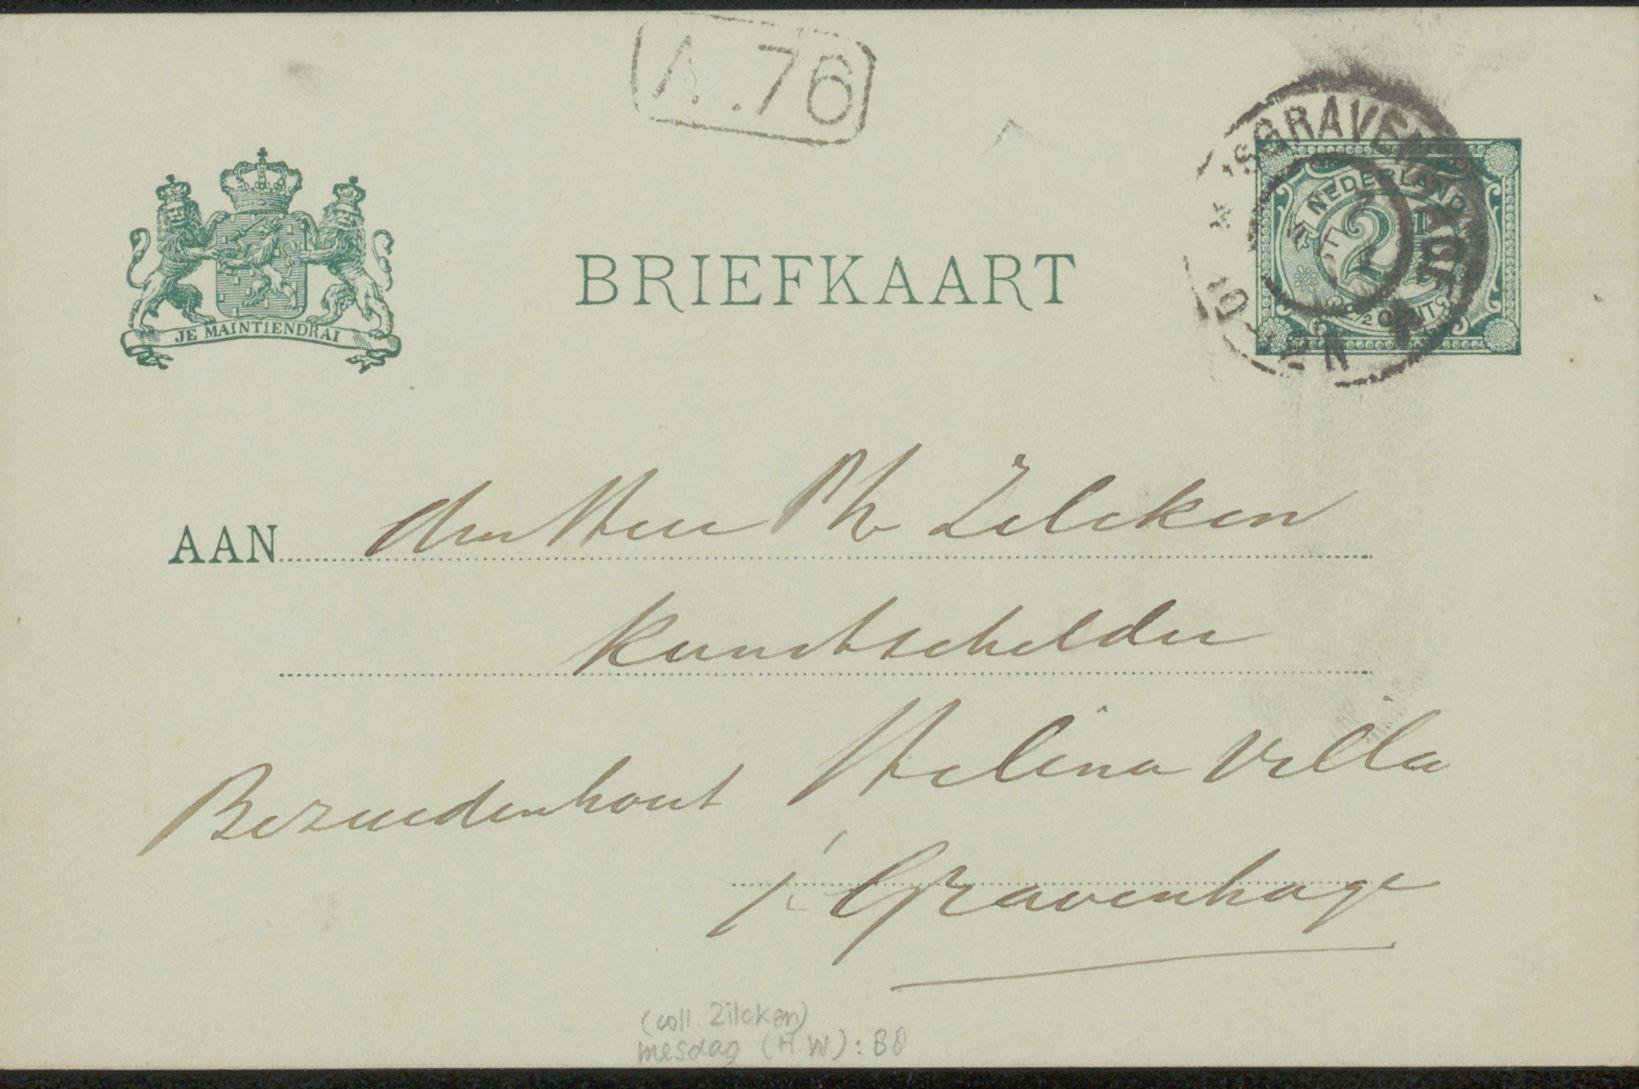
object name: postcard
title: Briefkaart aan Philip Zilcken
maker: hendrik willem mesdag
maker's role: draughtsman, painter, print maker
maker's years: 1831-1915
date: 1903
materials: cardboard, ink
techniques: pen, writing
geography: the hague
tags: philip zilcken, exhibition ~ art